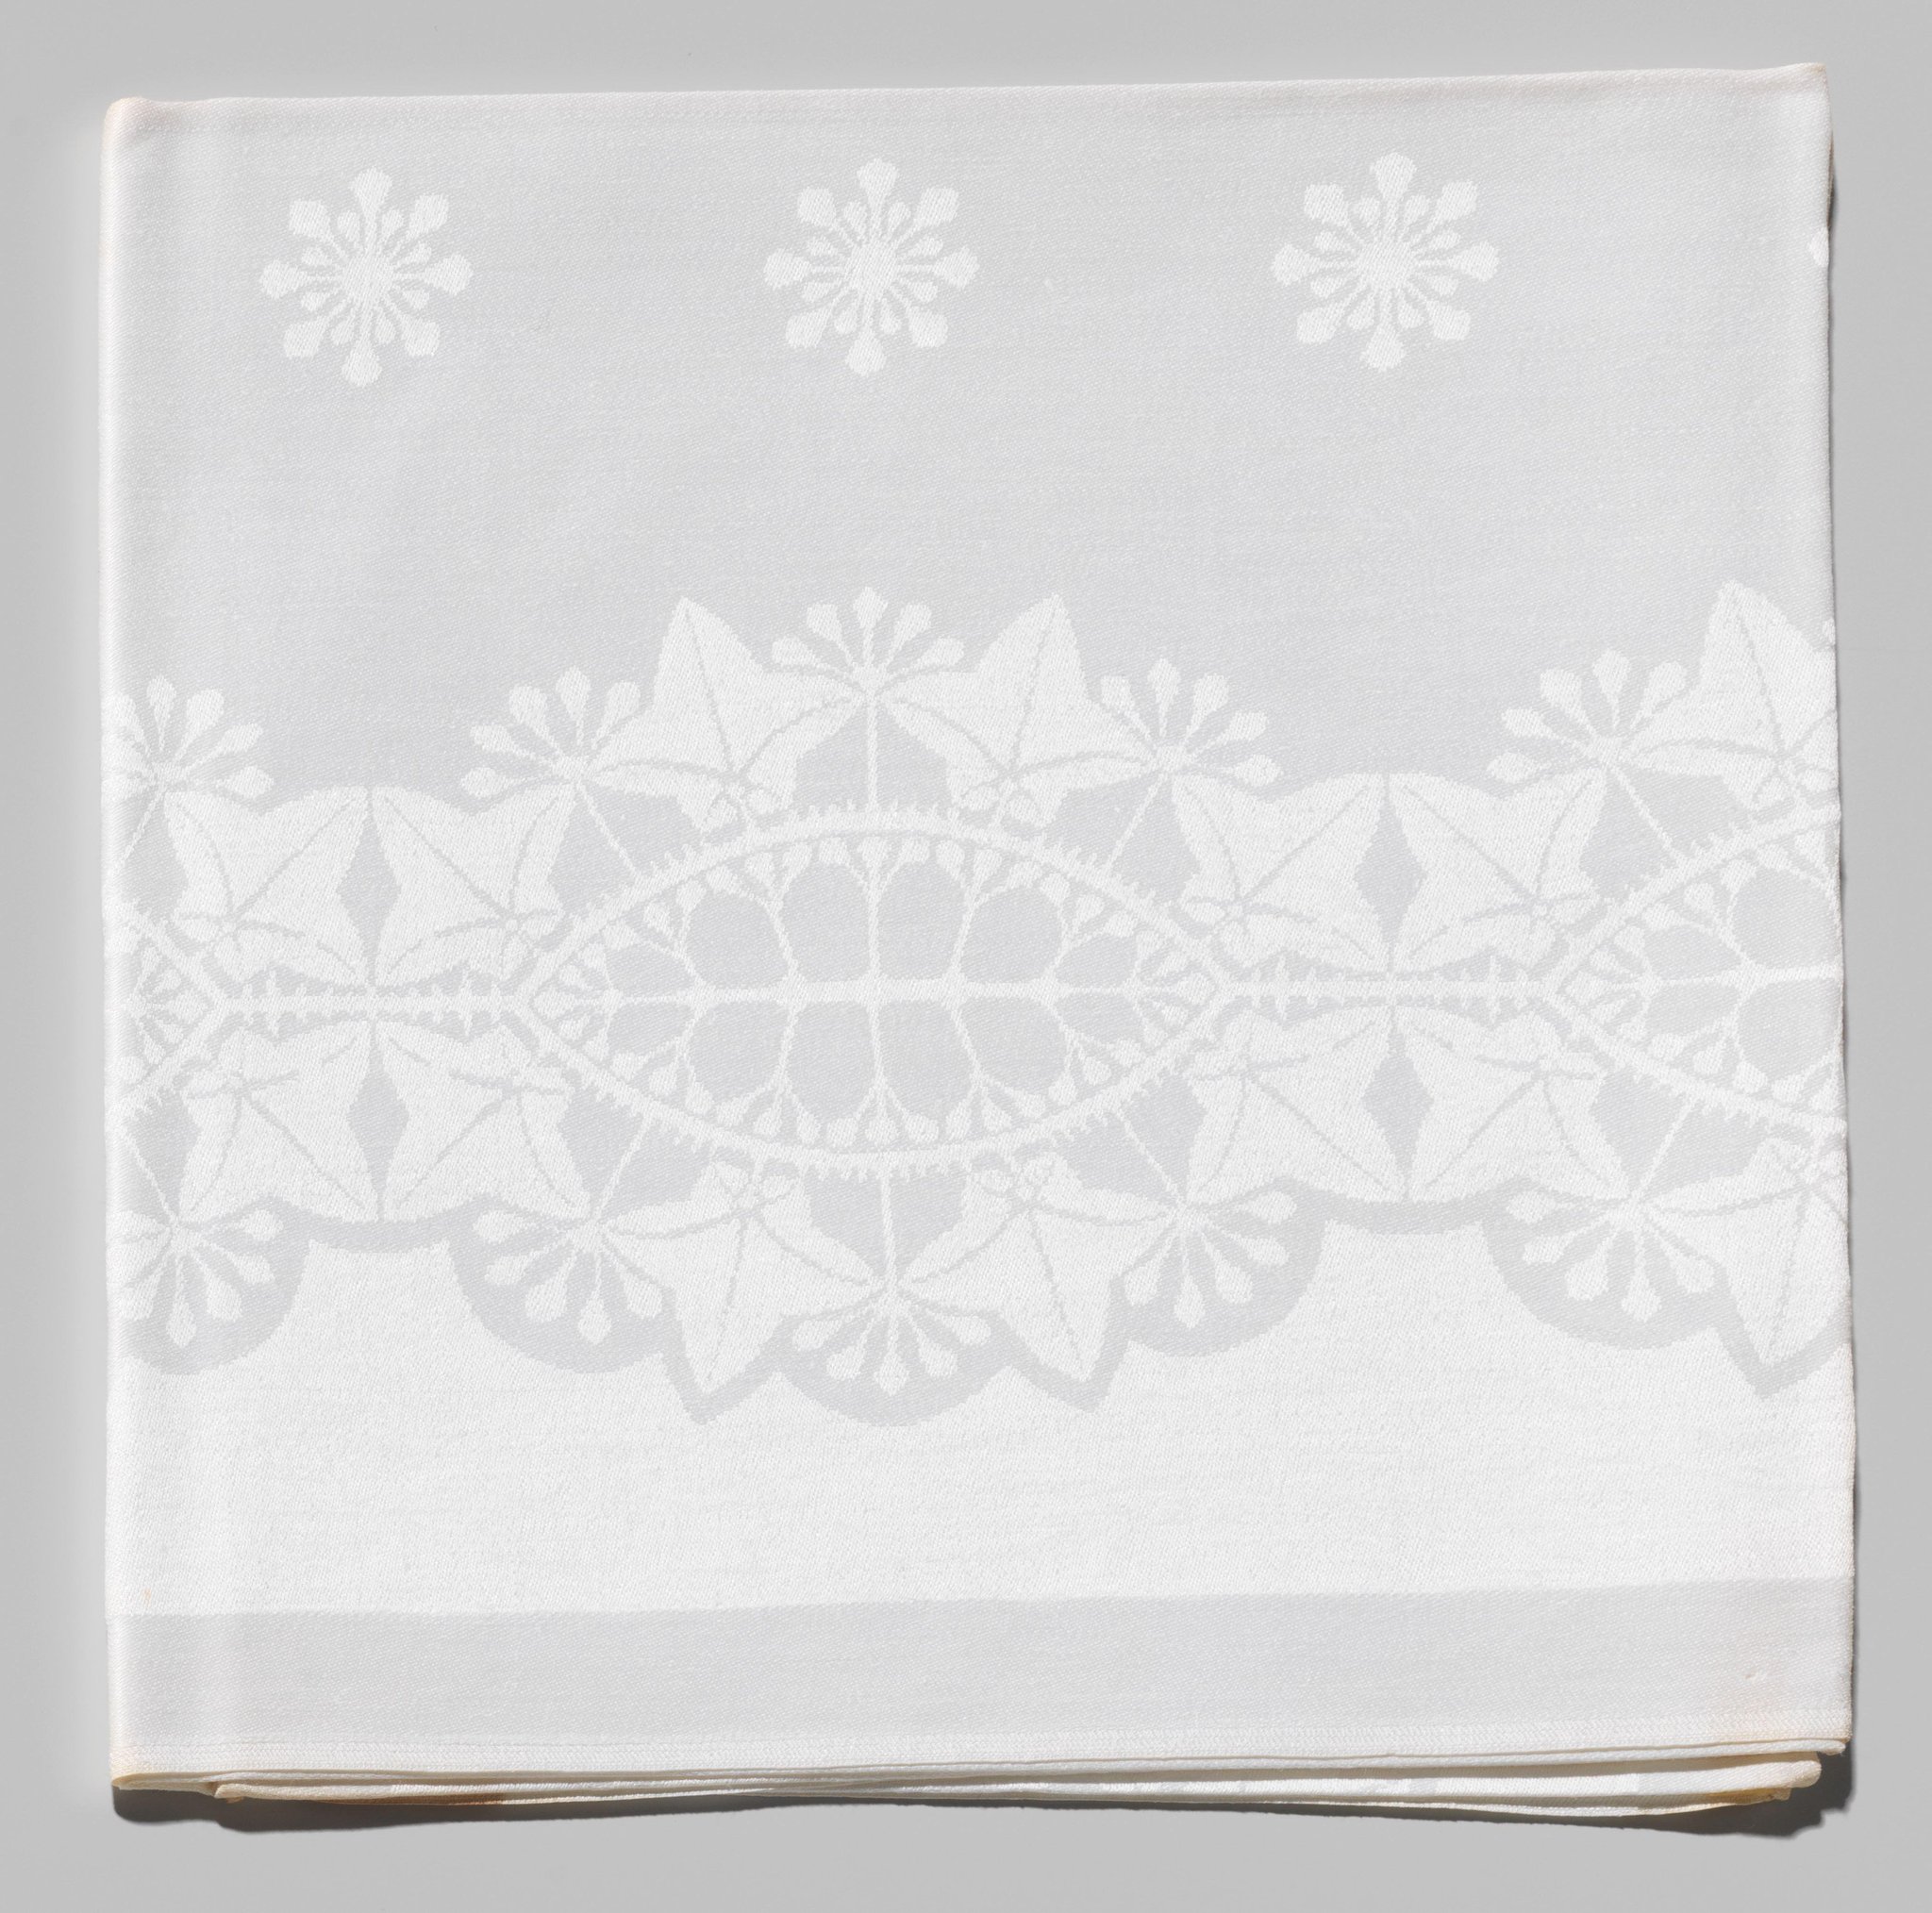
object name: napkin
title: Servet van linnendamast met klimop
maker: chris lebeau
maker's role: draughtsman, print maker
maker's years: 1878-1945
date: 1904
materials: linen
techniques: damask, weave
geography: eindhoven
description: Servet van linnendamast met klimop: motief Klimop, dessin nr. 513. Het servet hoort bij elf servetten (BK-1979-262-A t/m BK-1979-262-L) en twee tafellakens (BK-1979-261-A en BK-1979-261-B).